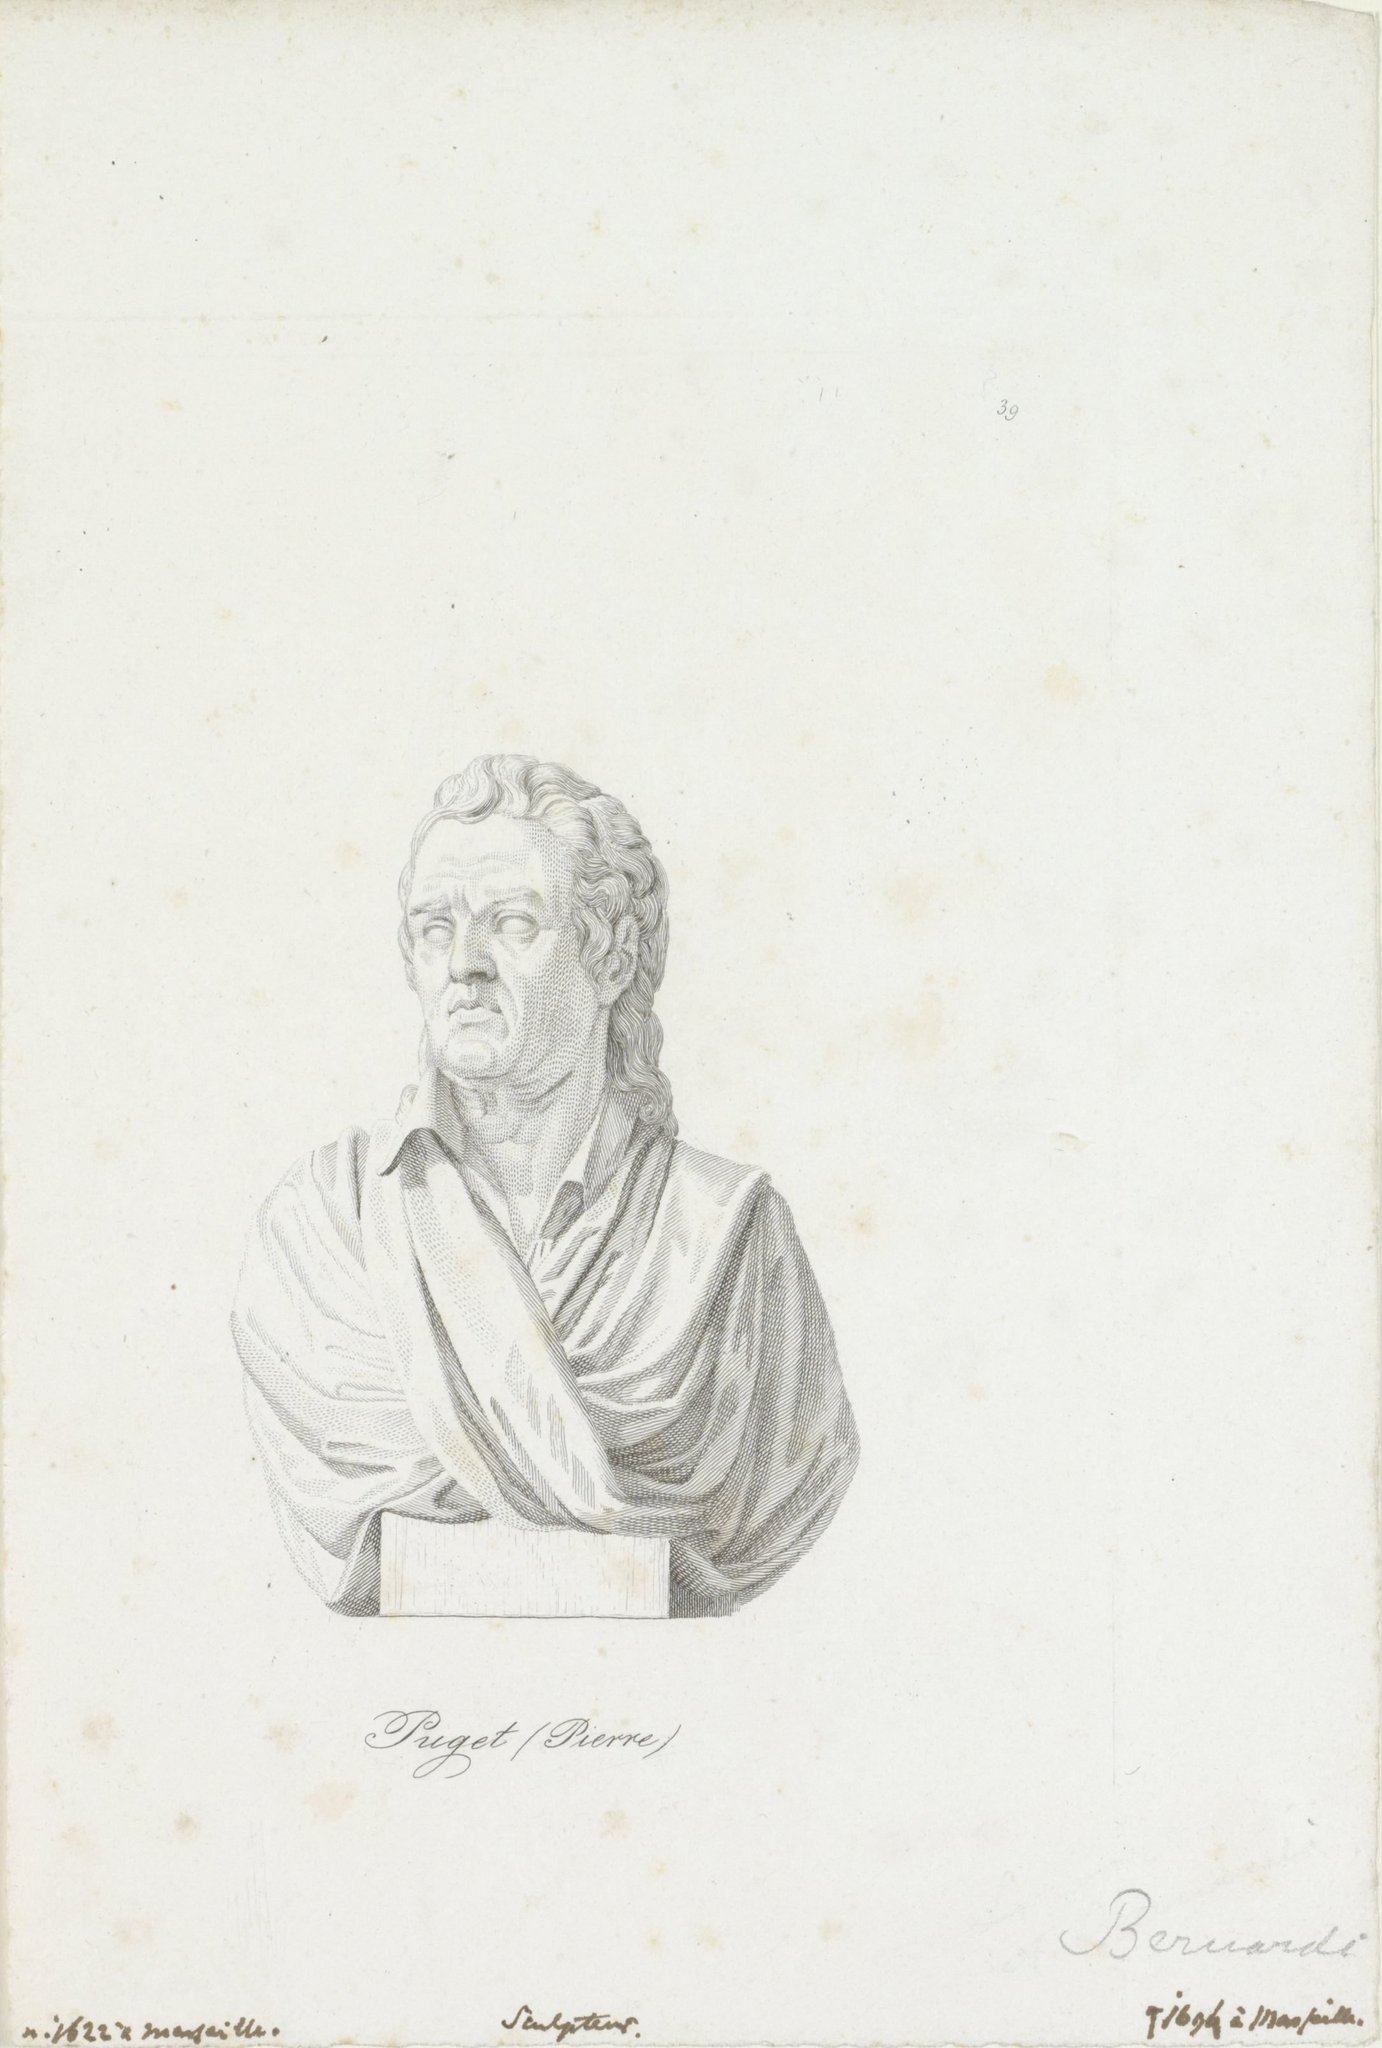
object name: print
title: Galerie historique de Versailles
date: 1818-1848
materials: paper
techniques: engraving, etching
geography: paris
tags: painter, engineer, sculptor, historical persons, piece of sculpture, reproduction of a piece of sculpture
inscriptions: collector's mark: Lugt 2228